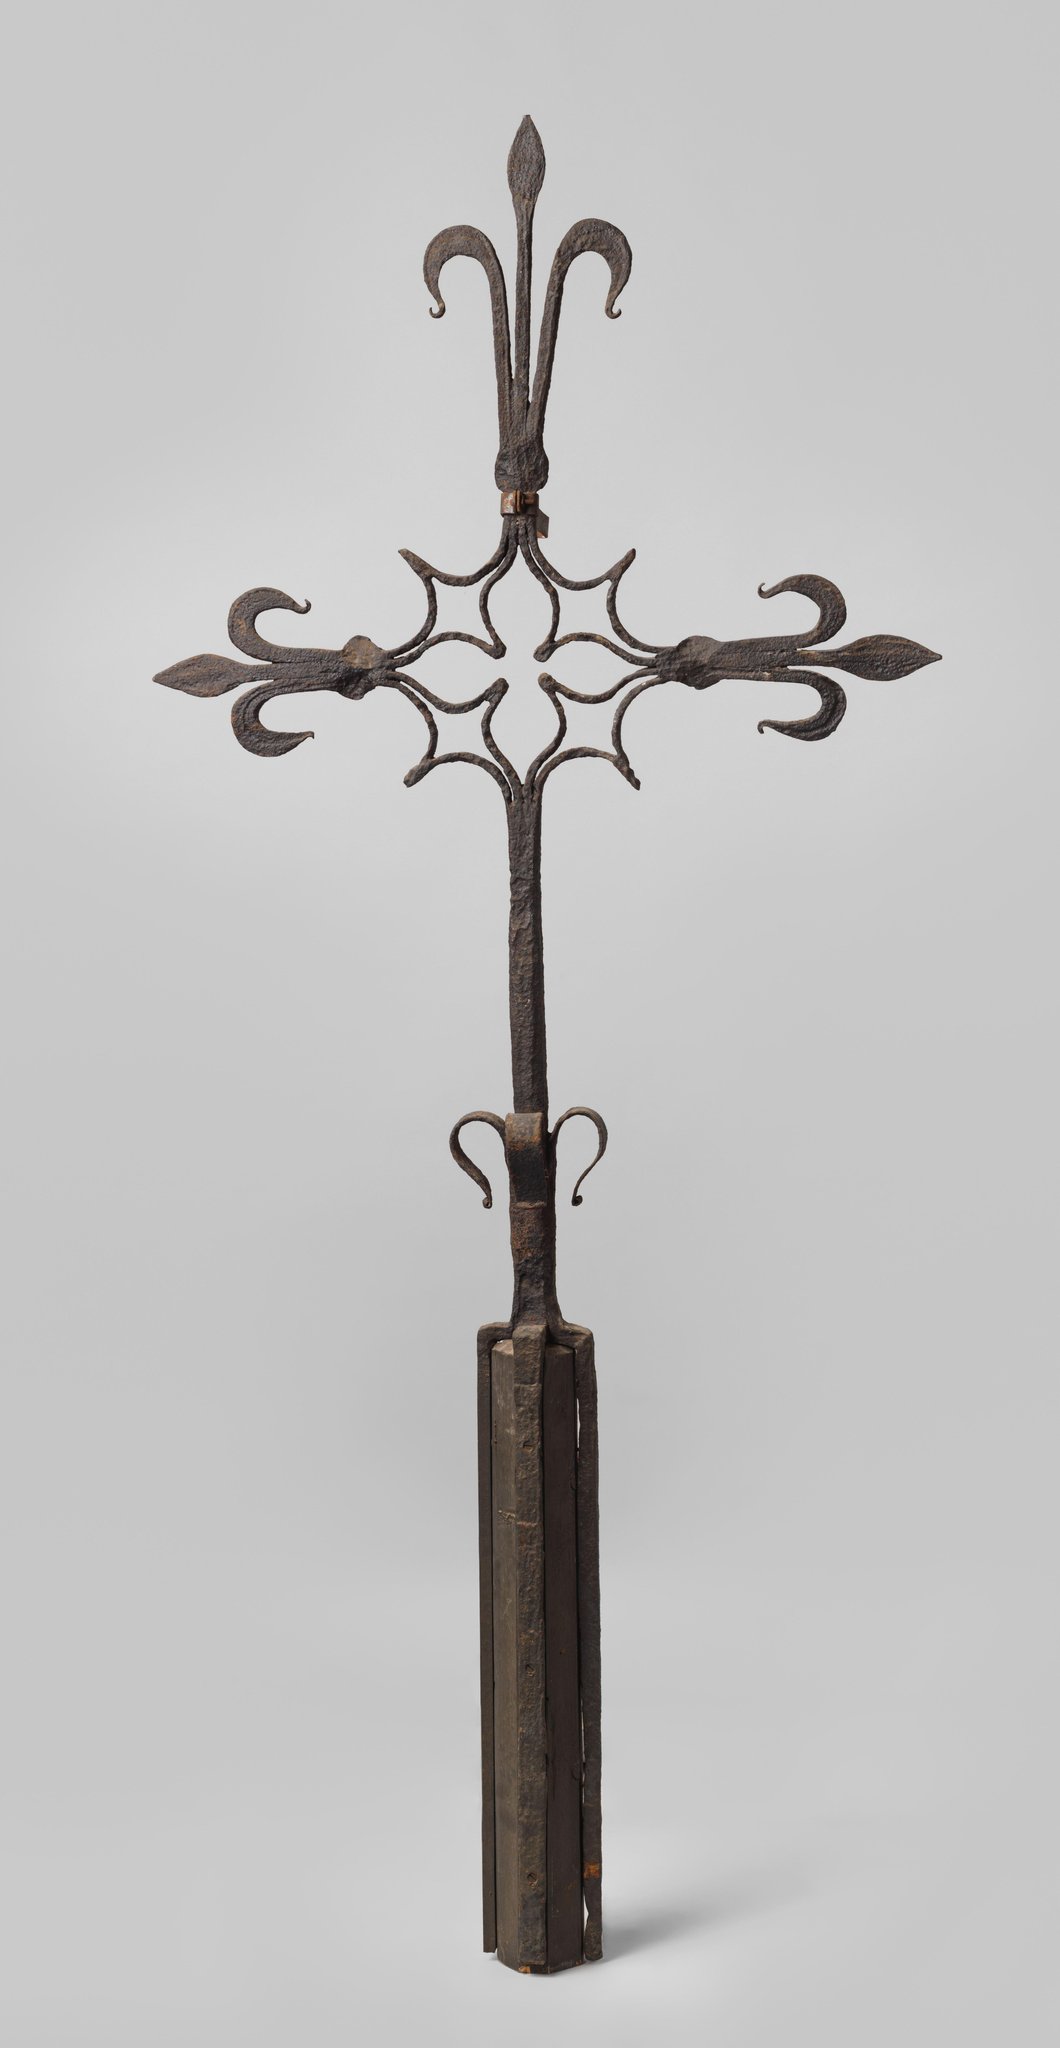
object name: torenkruis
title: Torenkruis, afkomstig uit Zeeland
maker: Anonymous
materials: iron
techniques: forging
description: Torenkruis van smeedijzer, uitgevoerd in gotische stijl. Afkomstig uit Zeeland.